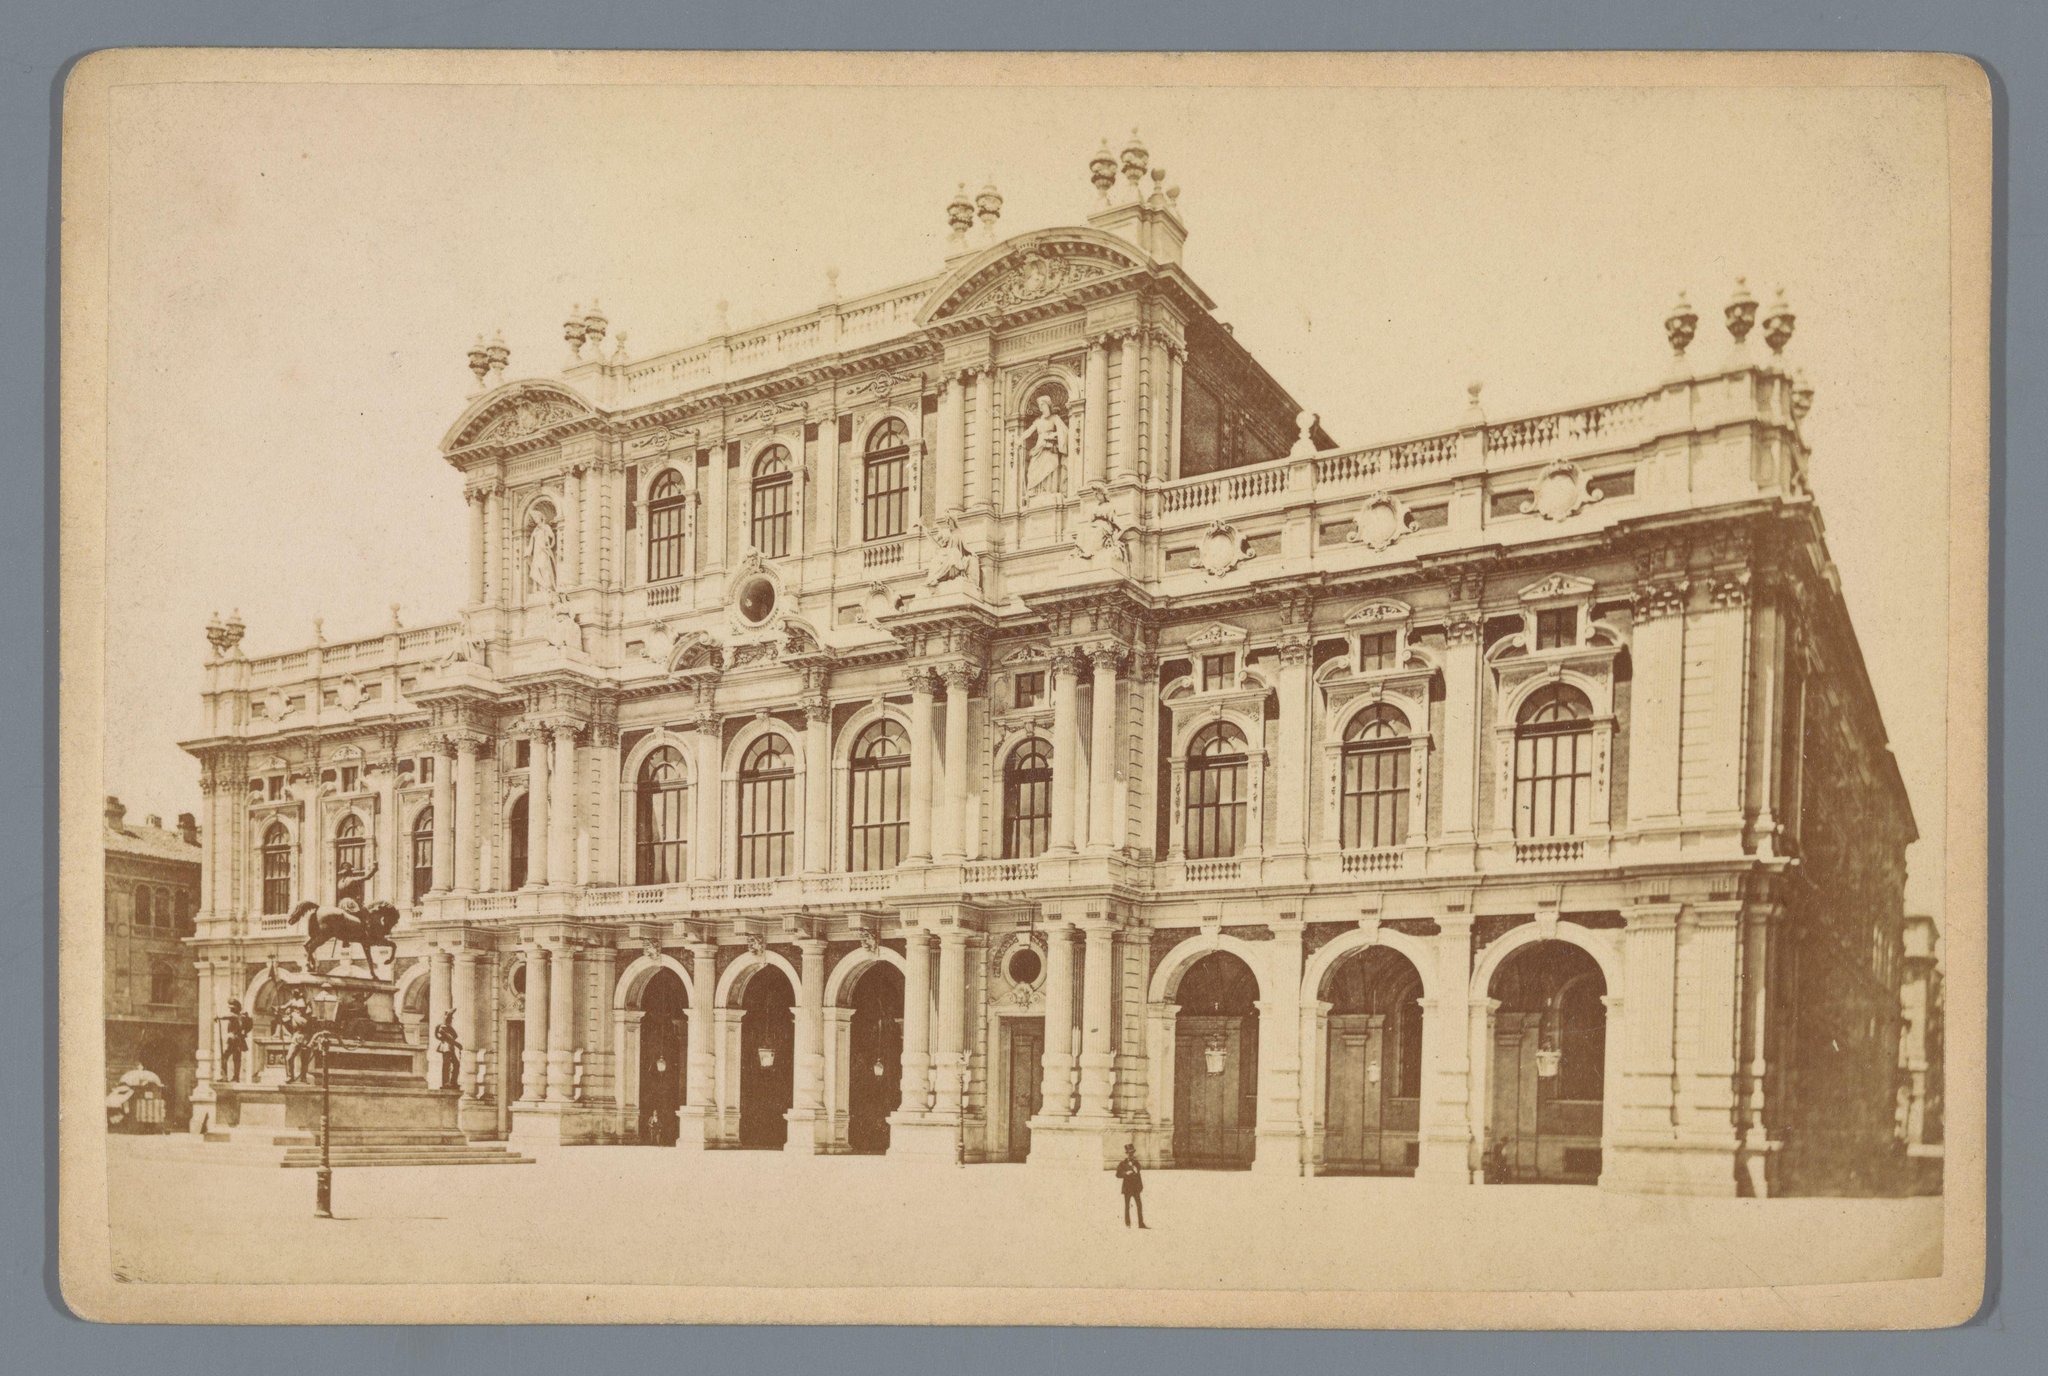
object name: cabinet photograph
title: Gezicht op de façade van Palazzo Carignano in Turijn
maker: Anonymous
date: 1850-1900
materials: cardboard, photographic support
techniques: albumen print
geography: palazzo carignano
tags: palace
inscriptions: annotation: ‘Palazzo Carignano Torino voorfaçade’